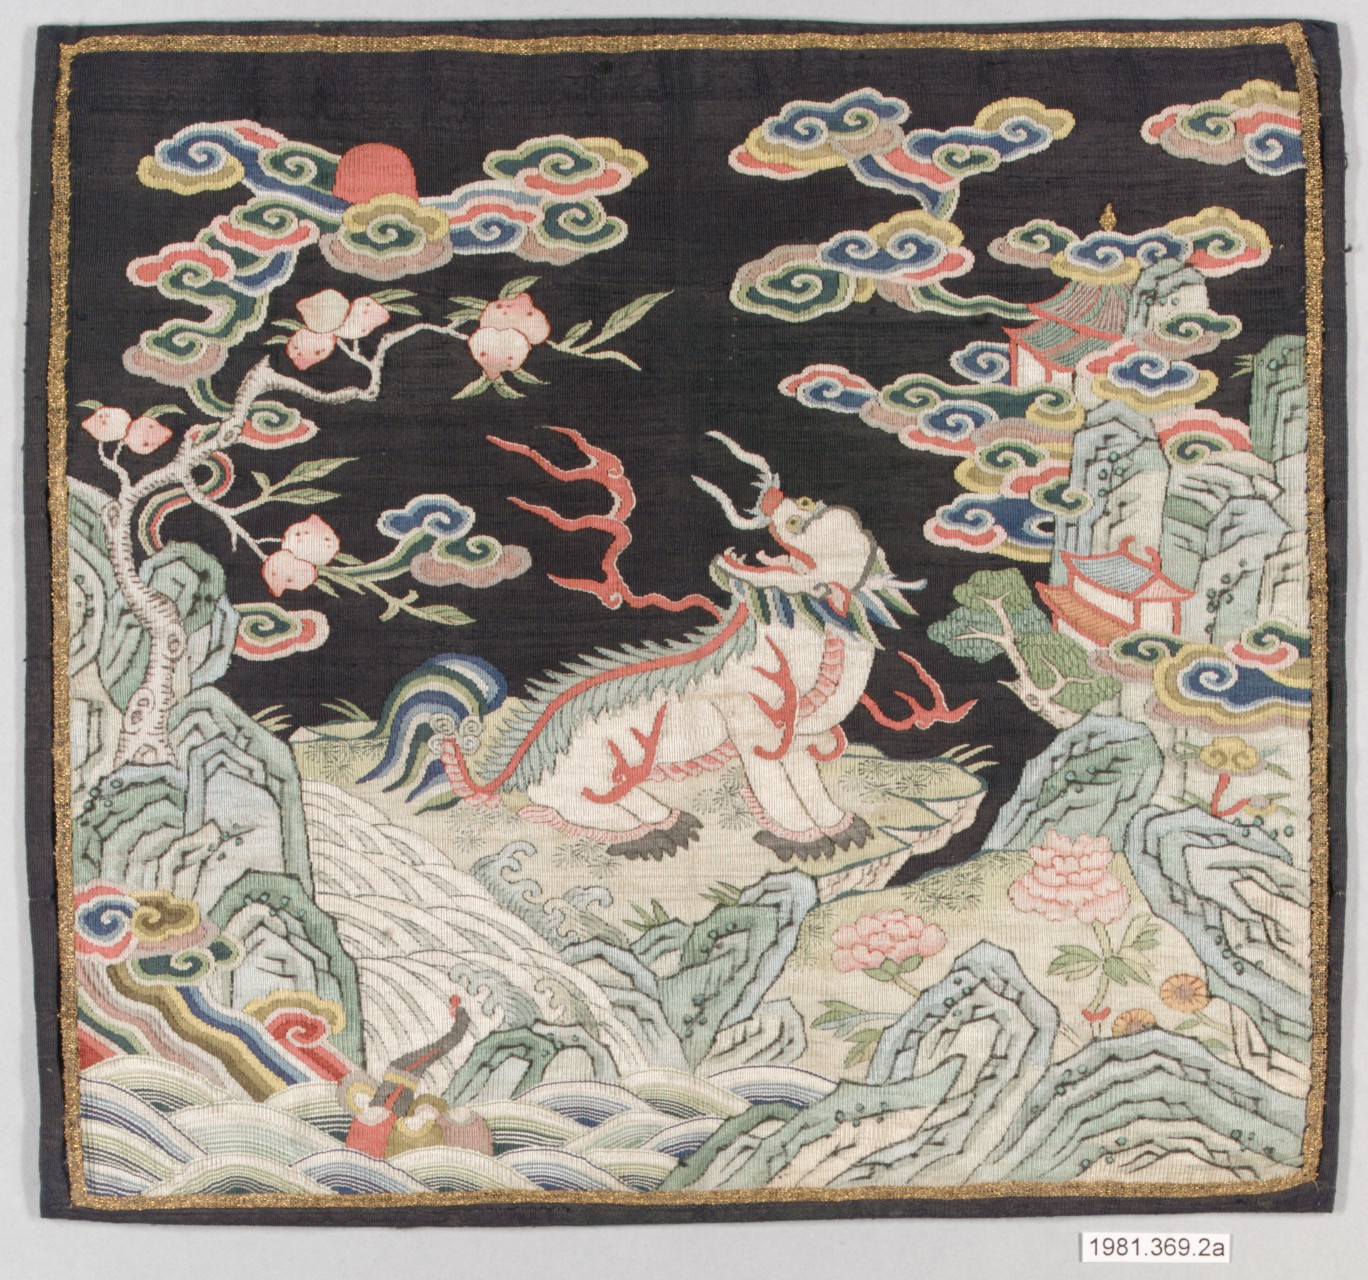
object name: rank badge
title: Rank Badge with Lions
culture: chinese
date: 1701-1800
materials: metal thread, silk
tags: lions